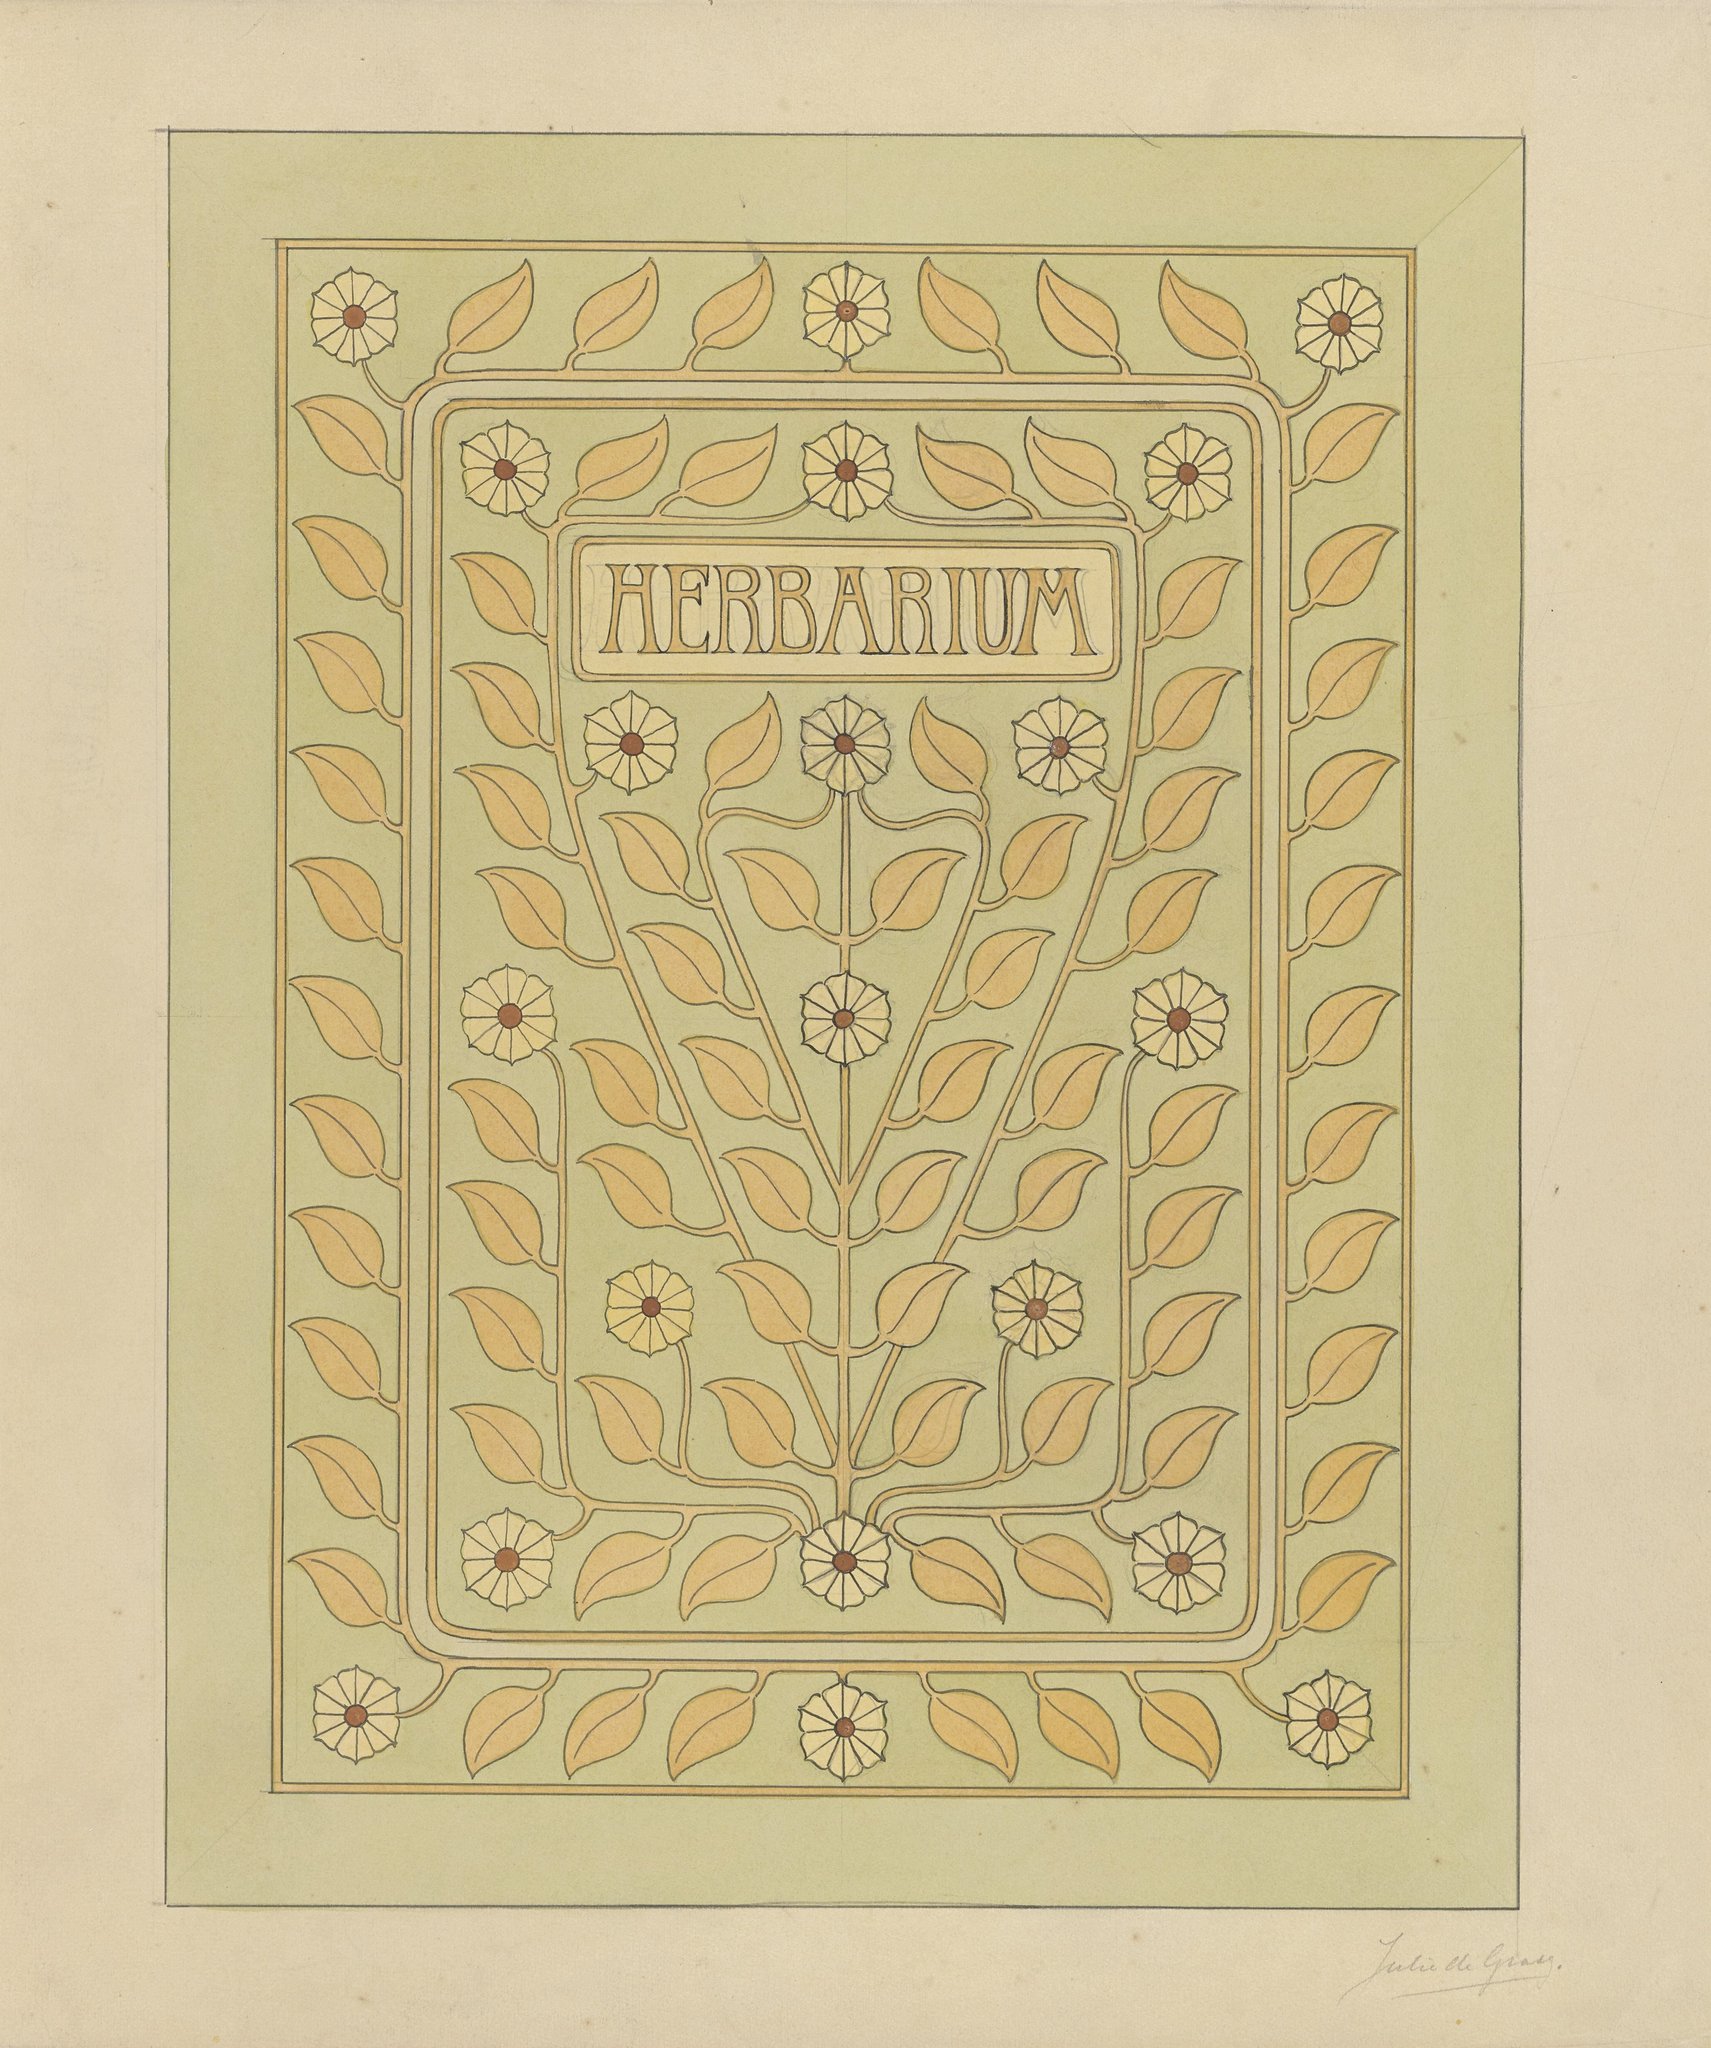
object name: drawing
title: Ontwerp voor een omslag voor een herbarium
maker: julie de graag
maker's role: draughtsman, print maker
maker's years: 1877-1924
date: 1887-1924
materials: ink, paper, pencil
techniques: brush, pen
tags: herbarium, foliage, tendrils, branches ~ ornament, flowers ~ ornament